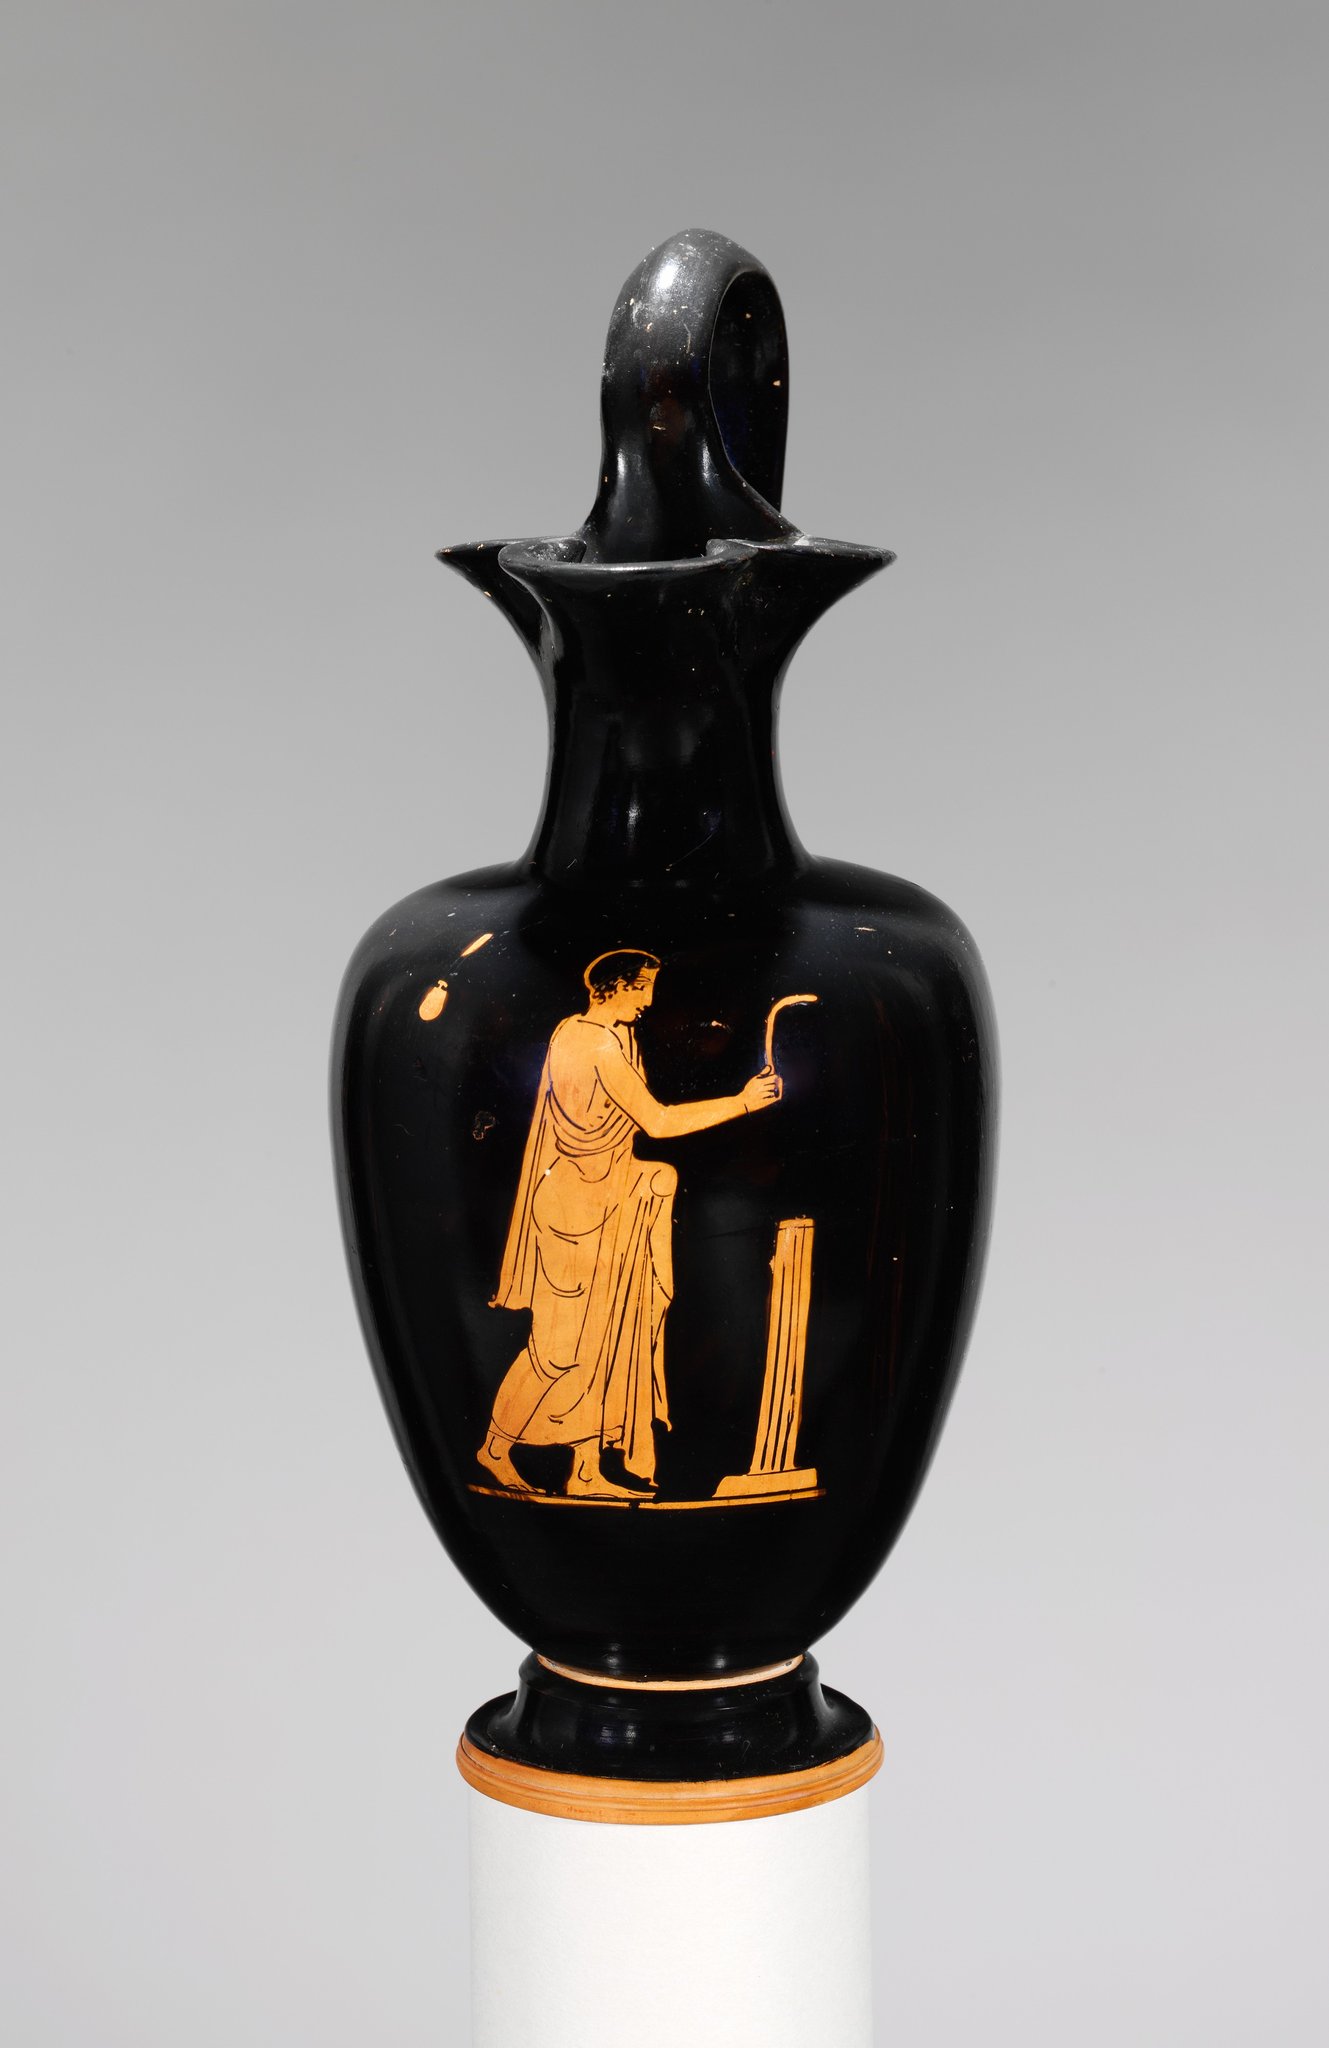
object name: oinochoe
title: Terracotta oinochoe (jug)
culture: greek, attic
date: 430 BCE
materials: terracotta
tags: men,athletes